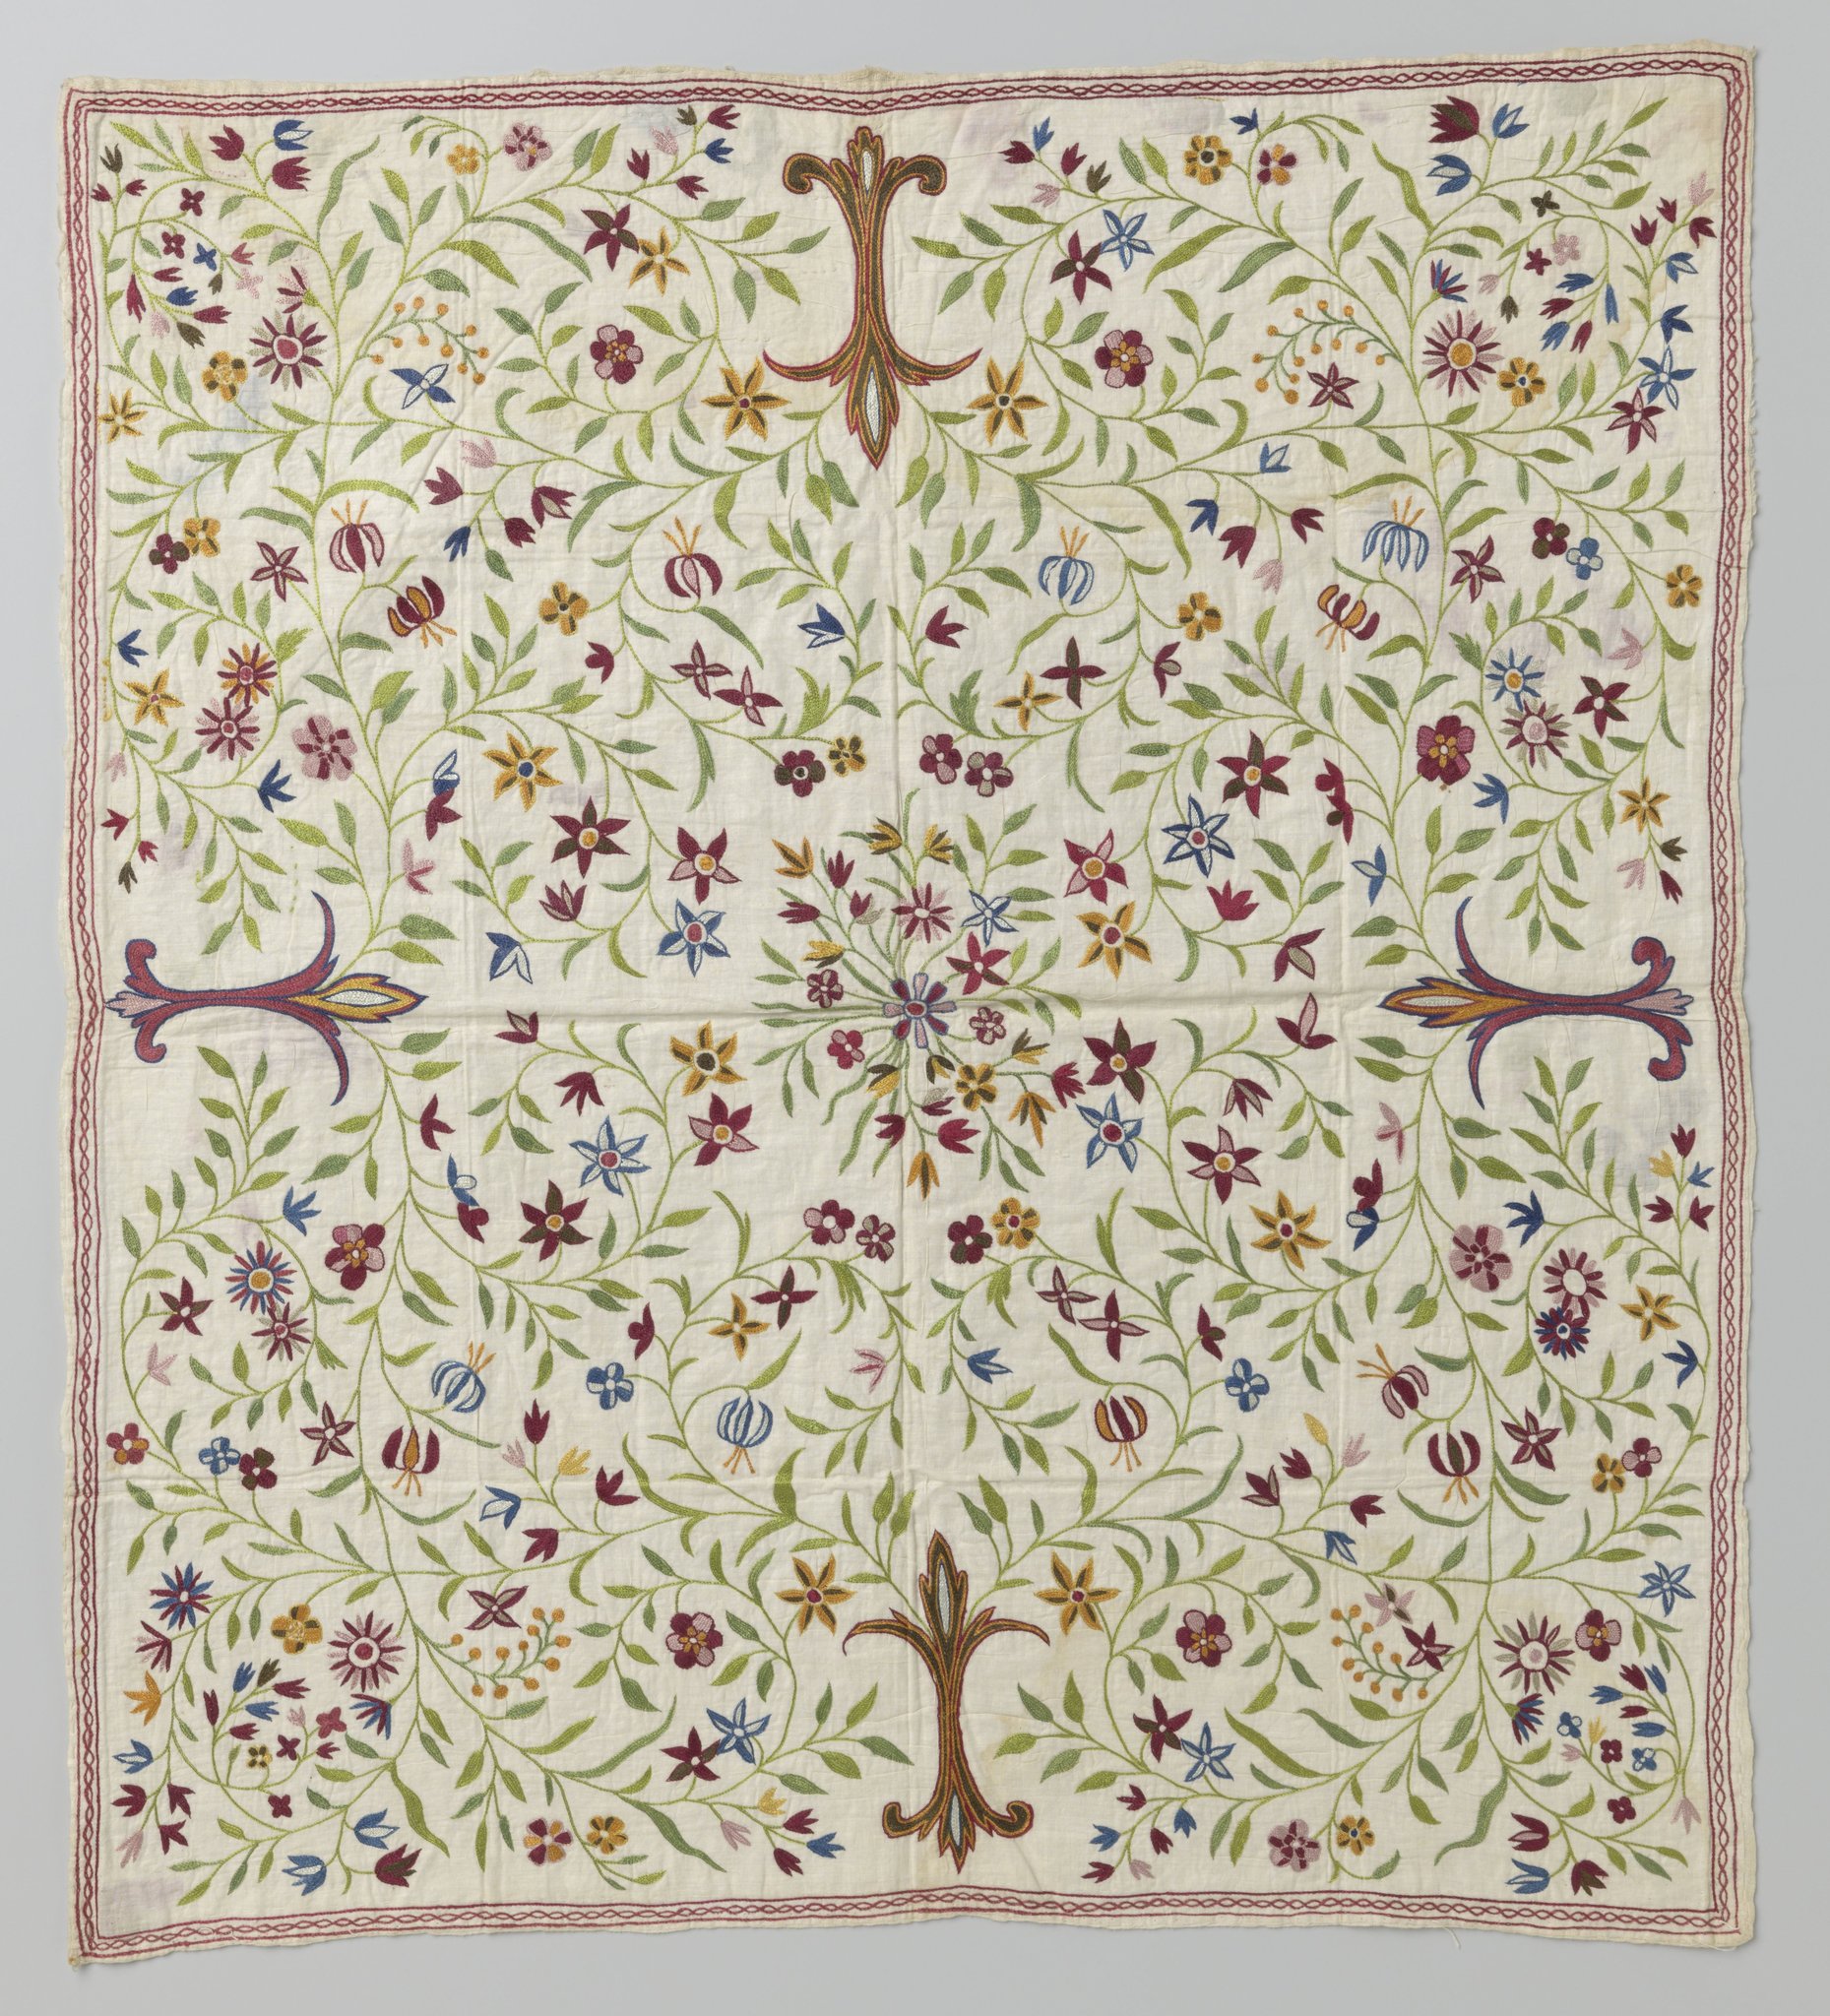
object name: textile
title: Kleed van oosterse textiel met veelkleurig borduurwerk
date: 1800-1899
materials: cotton, silk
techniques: embroidered, weave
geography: east indies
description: Kleed van veelkleurig getamboereerde katoen, versierd met bloemranken en ornament, gevoerd met katoen.